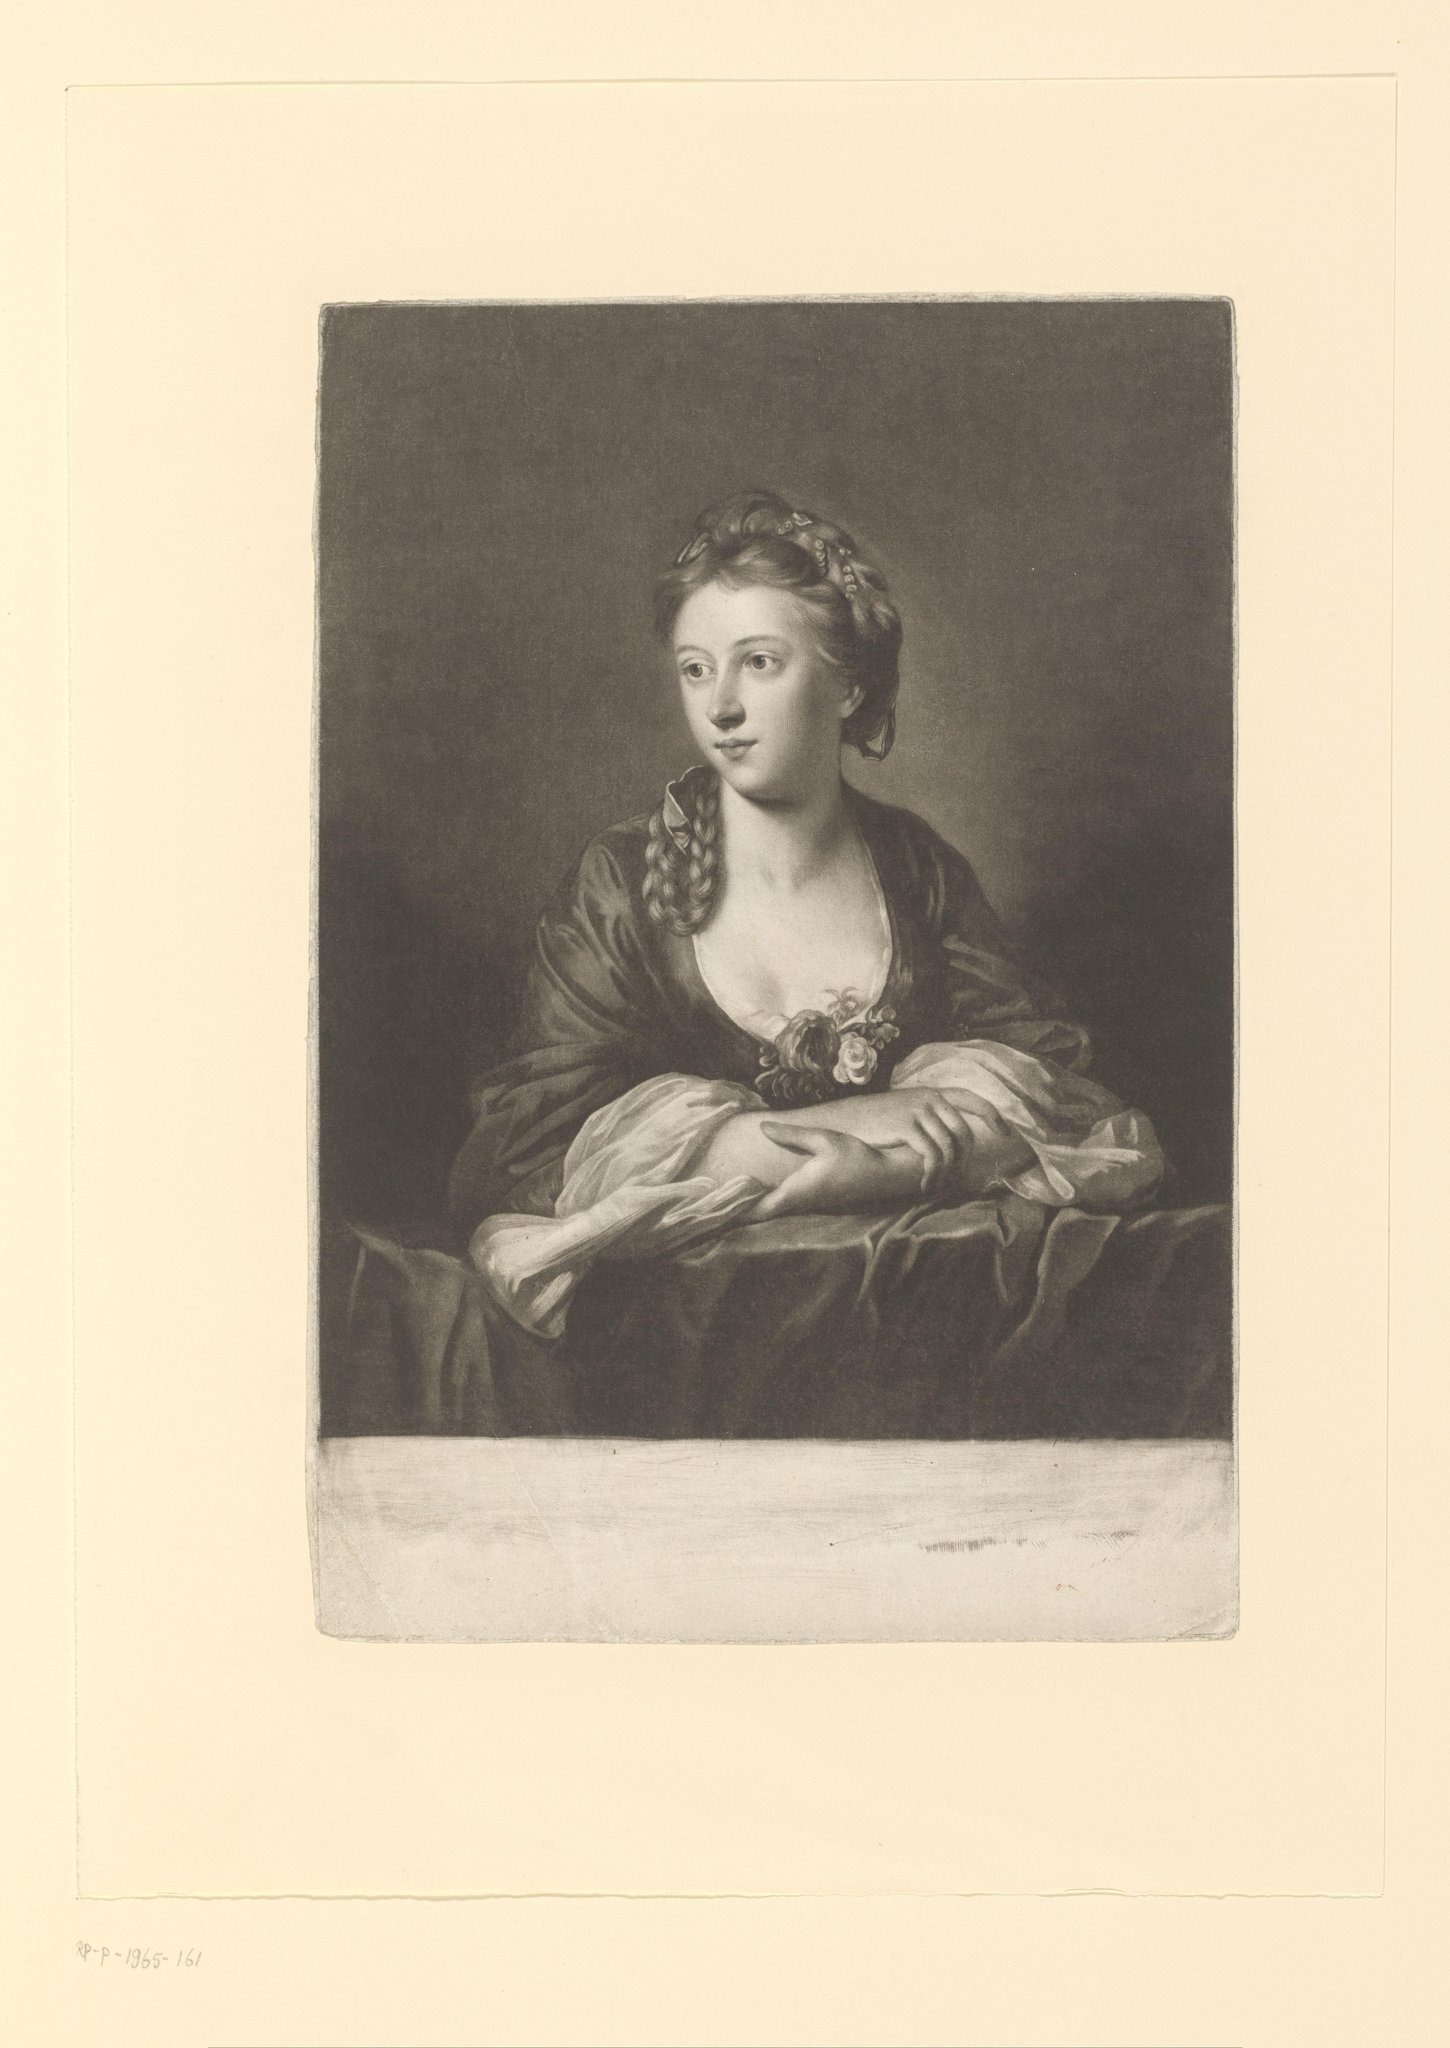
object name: print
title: Portret van Selina Hastings, hertogin van Huntingdon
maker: richard houston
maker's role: print maker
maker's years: 1721-1775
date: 1731-1775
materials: paper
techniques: mezzotint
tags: theologian, historical persons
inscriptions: collector's mark: Lugt 2228